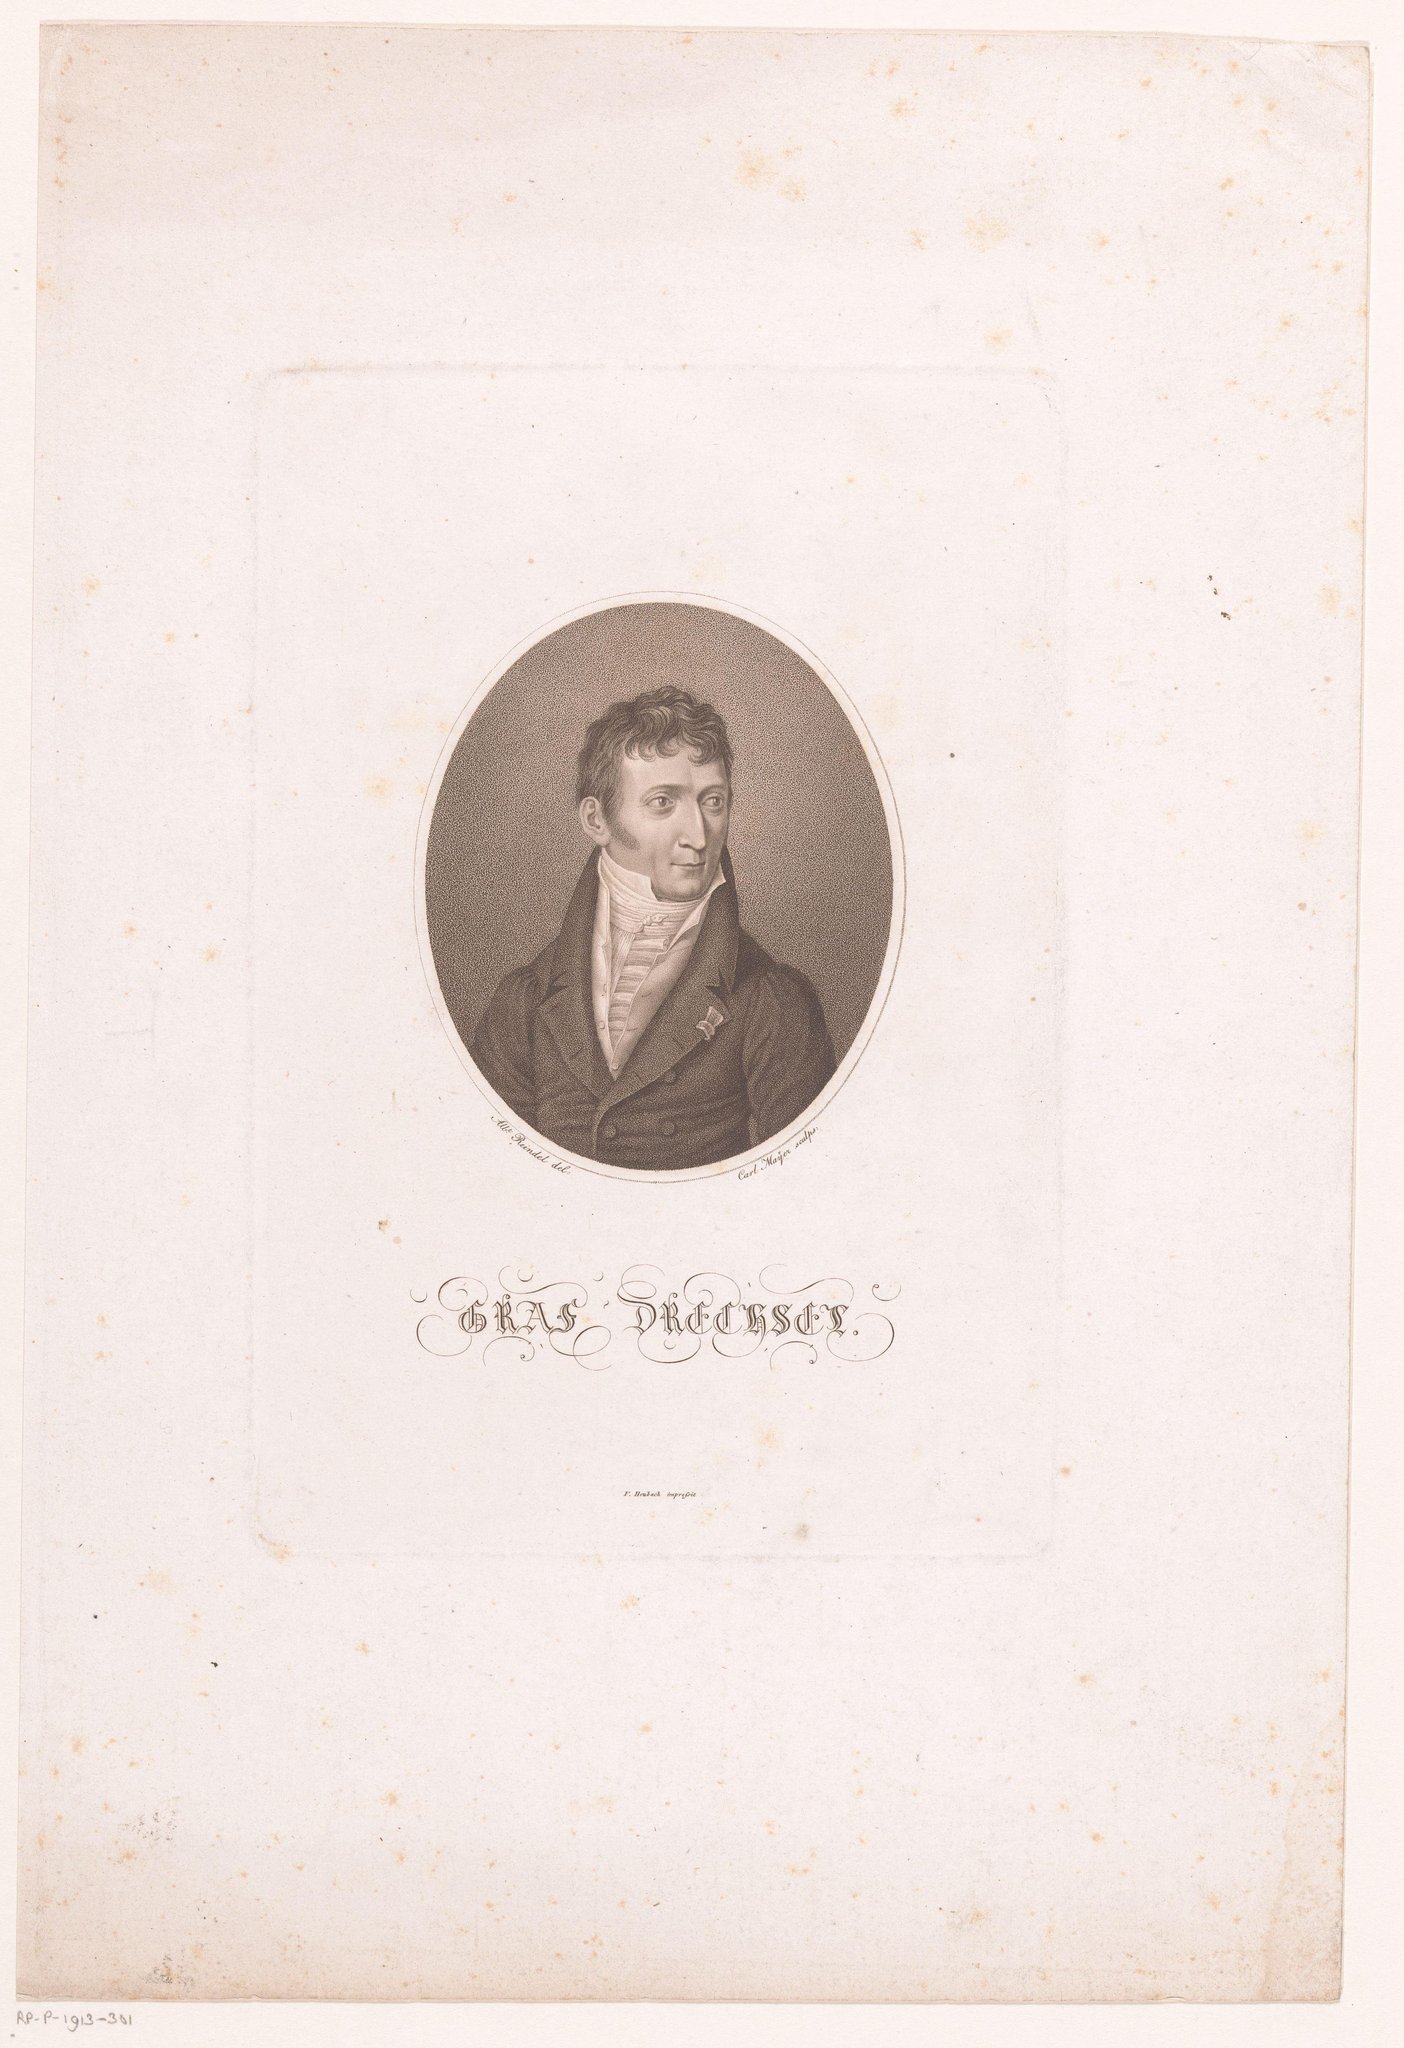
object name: print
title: Portret van Karl Joseph von Drechsel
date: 1808-1868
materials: paper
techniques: stippling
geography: nuremberg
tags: historical persons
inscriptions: collector's mark: Lugt 2228